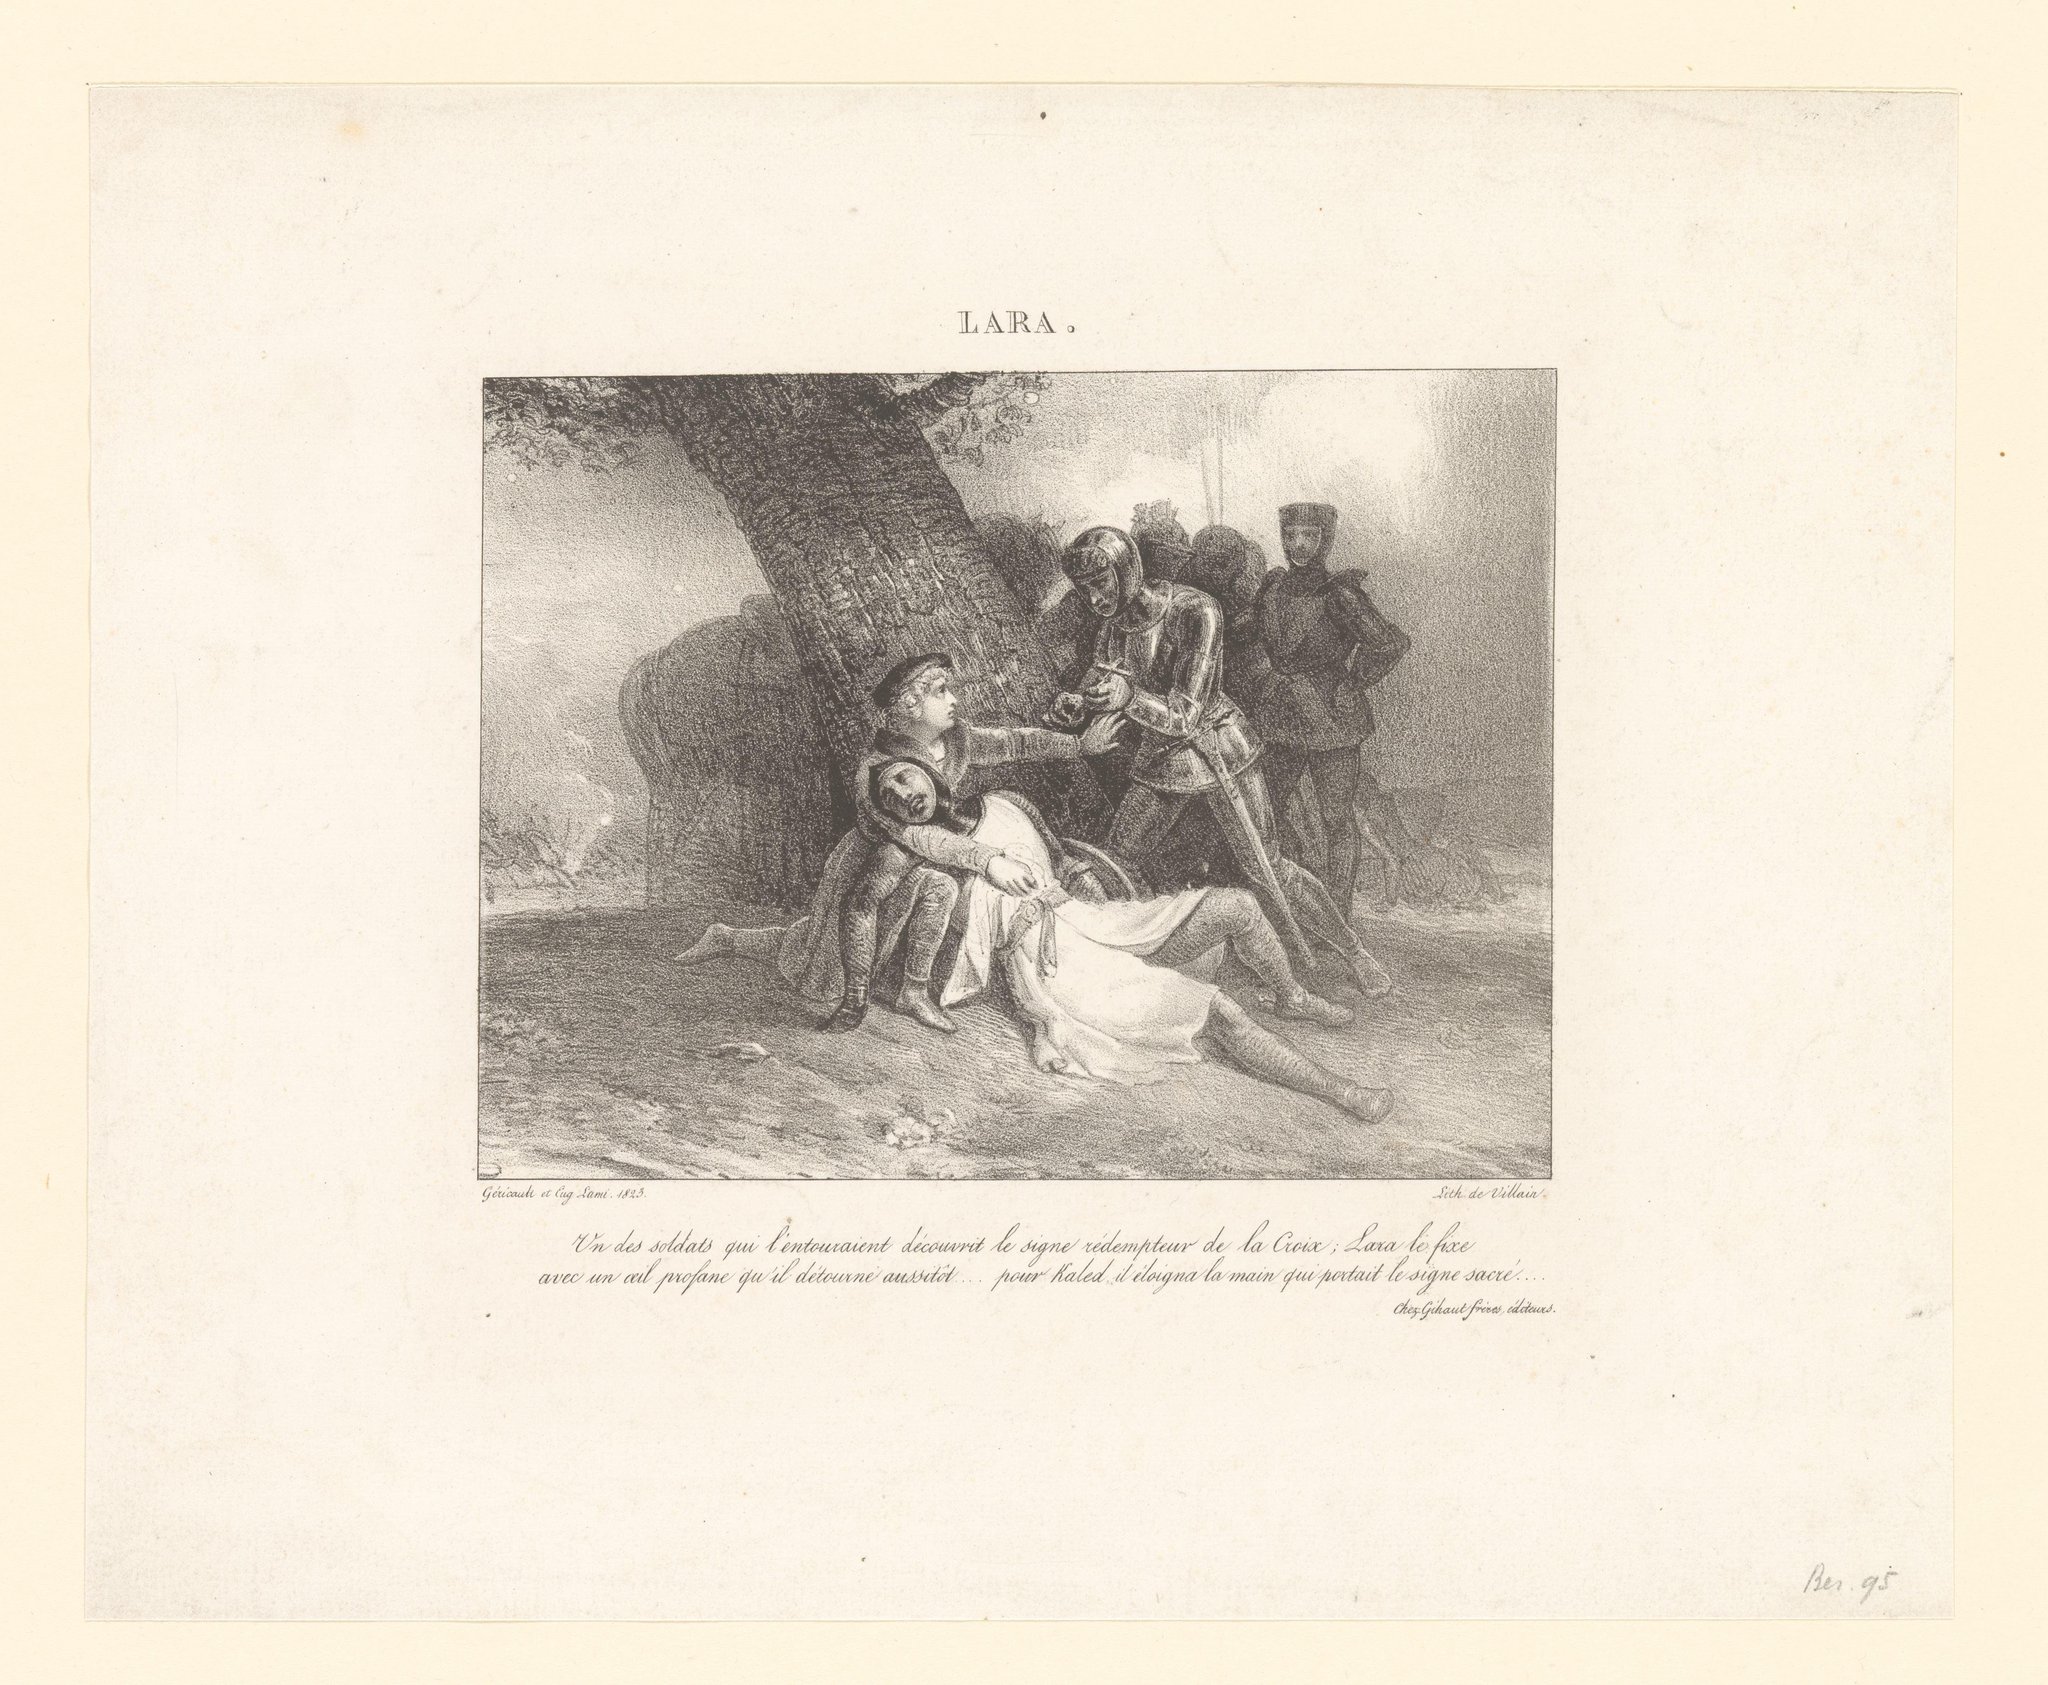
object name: print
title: Stervende man met ridders bij een boom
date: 1823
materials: paper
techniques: lithograph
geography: paris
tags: dying, knight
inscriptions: collector's mark: Lugt 2228